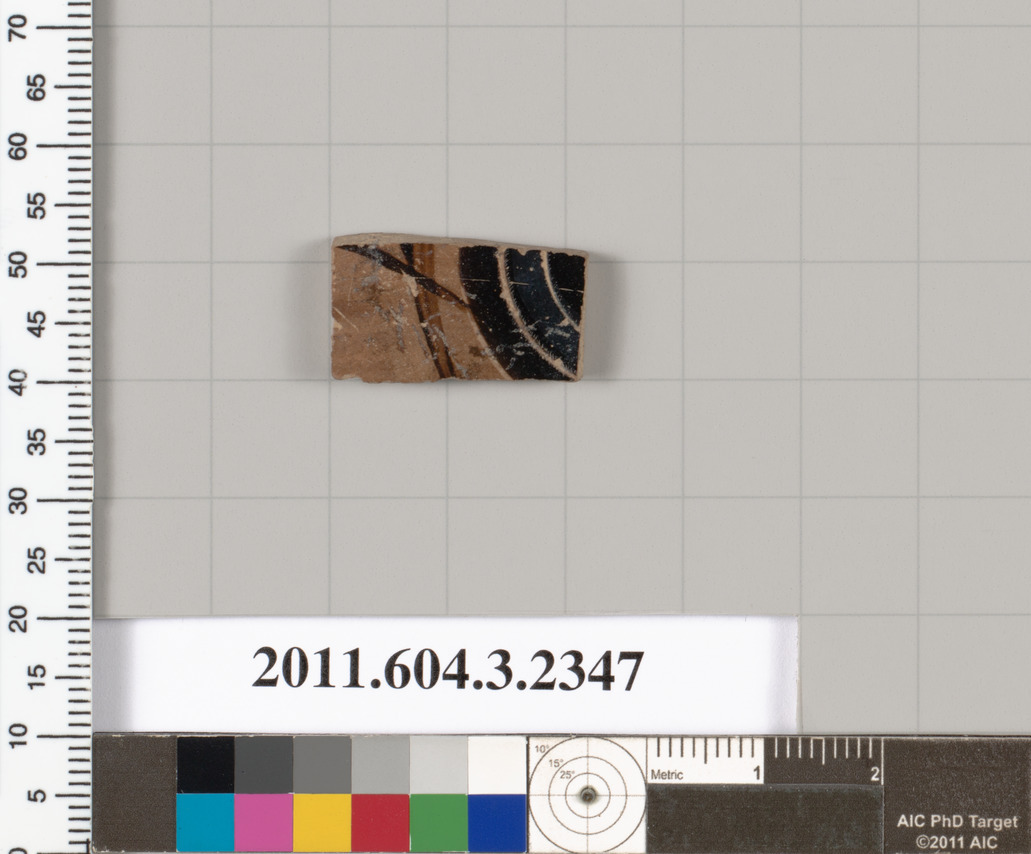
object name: kylix fragment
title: Terracotta fragment of a kylix: eye-cup (drinking cup)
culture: greek, attic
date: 540-520 BCE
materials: terracotta